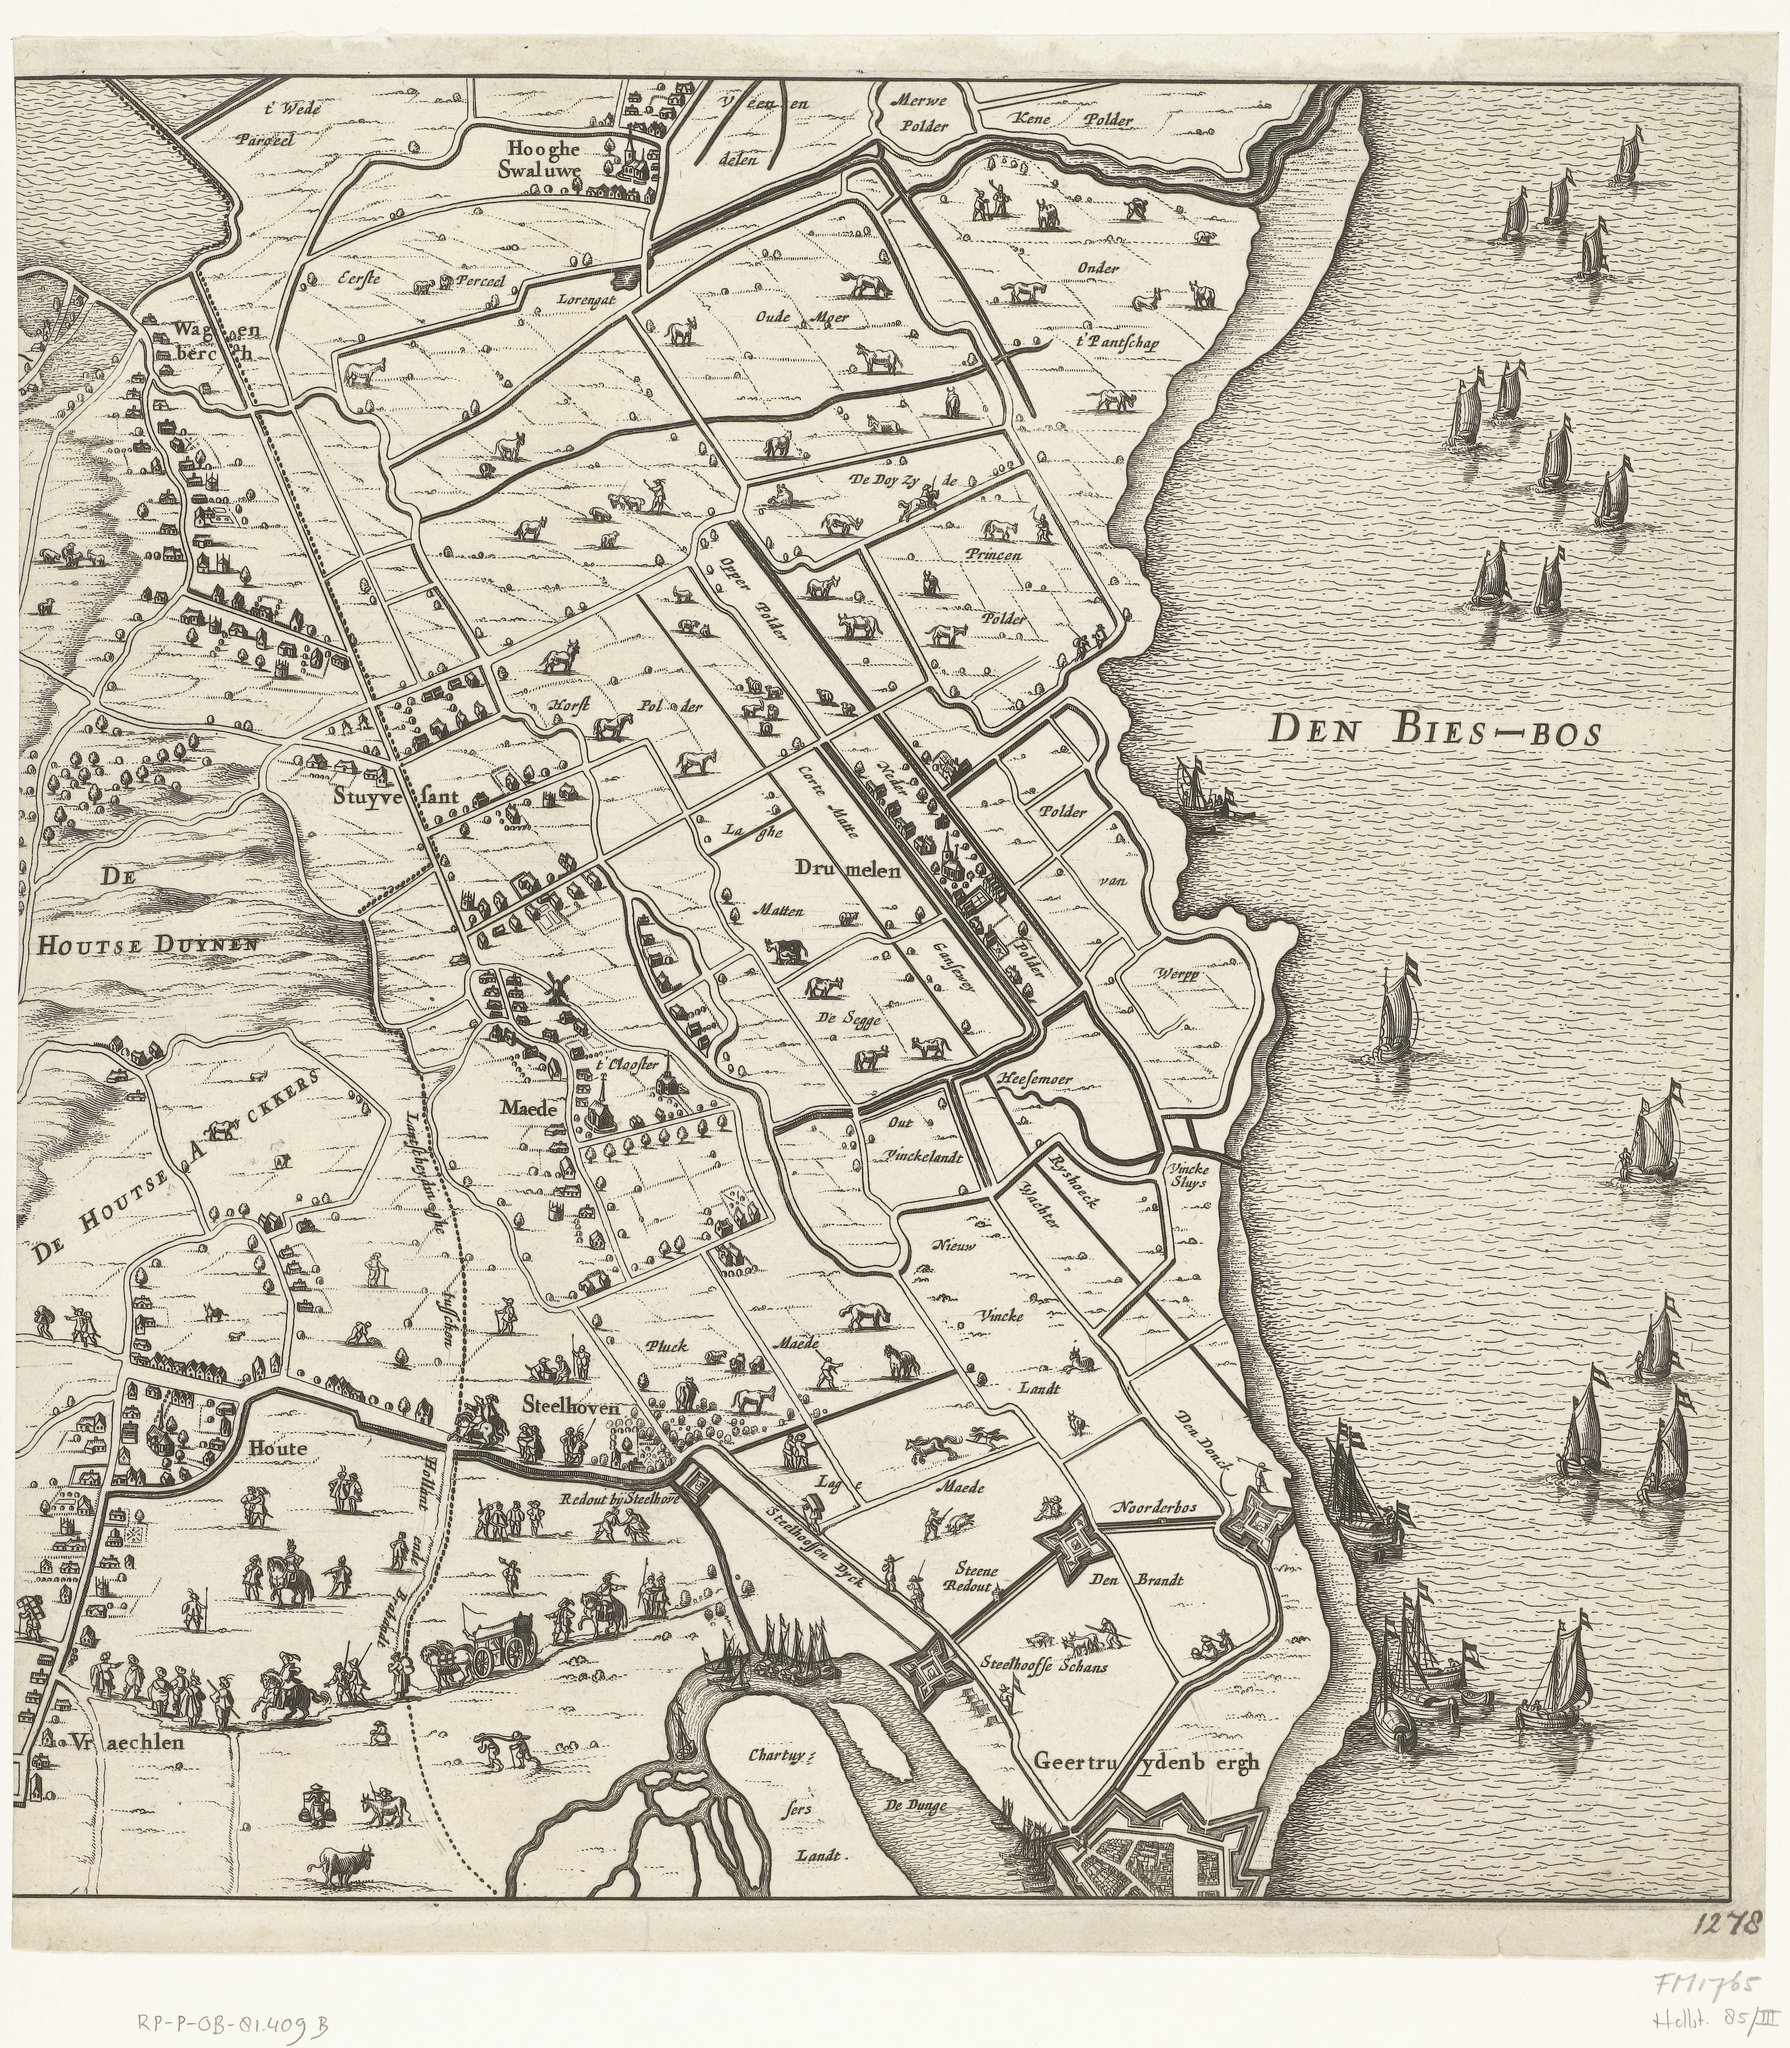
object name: print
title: Beleg van Breda (rechter blad), 1637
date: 1637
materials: paper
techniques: etching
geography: northern netherlands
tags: the hague, frederick henry (prince of orange), maps of separate countries or regions, siege, position war, geertruidenberg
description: Belegering en verovering van Breda door het Staatse leger onder Frederik Hendrik, 23 juli - 10 oktober 1637. Grote kaart van de stad en omgeving bestaande uit drie bladen waarvan dit het rechter blad is. Onderaan Geertruidenberg, rechts de Biesbos.